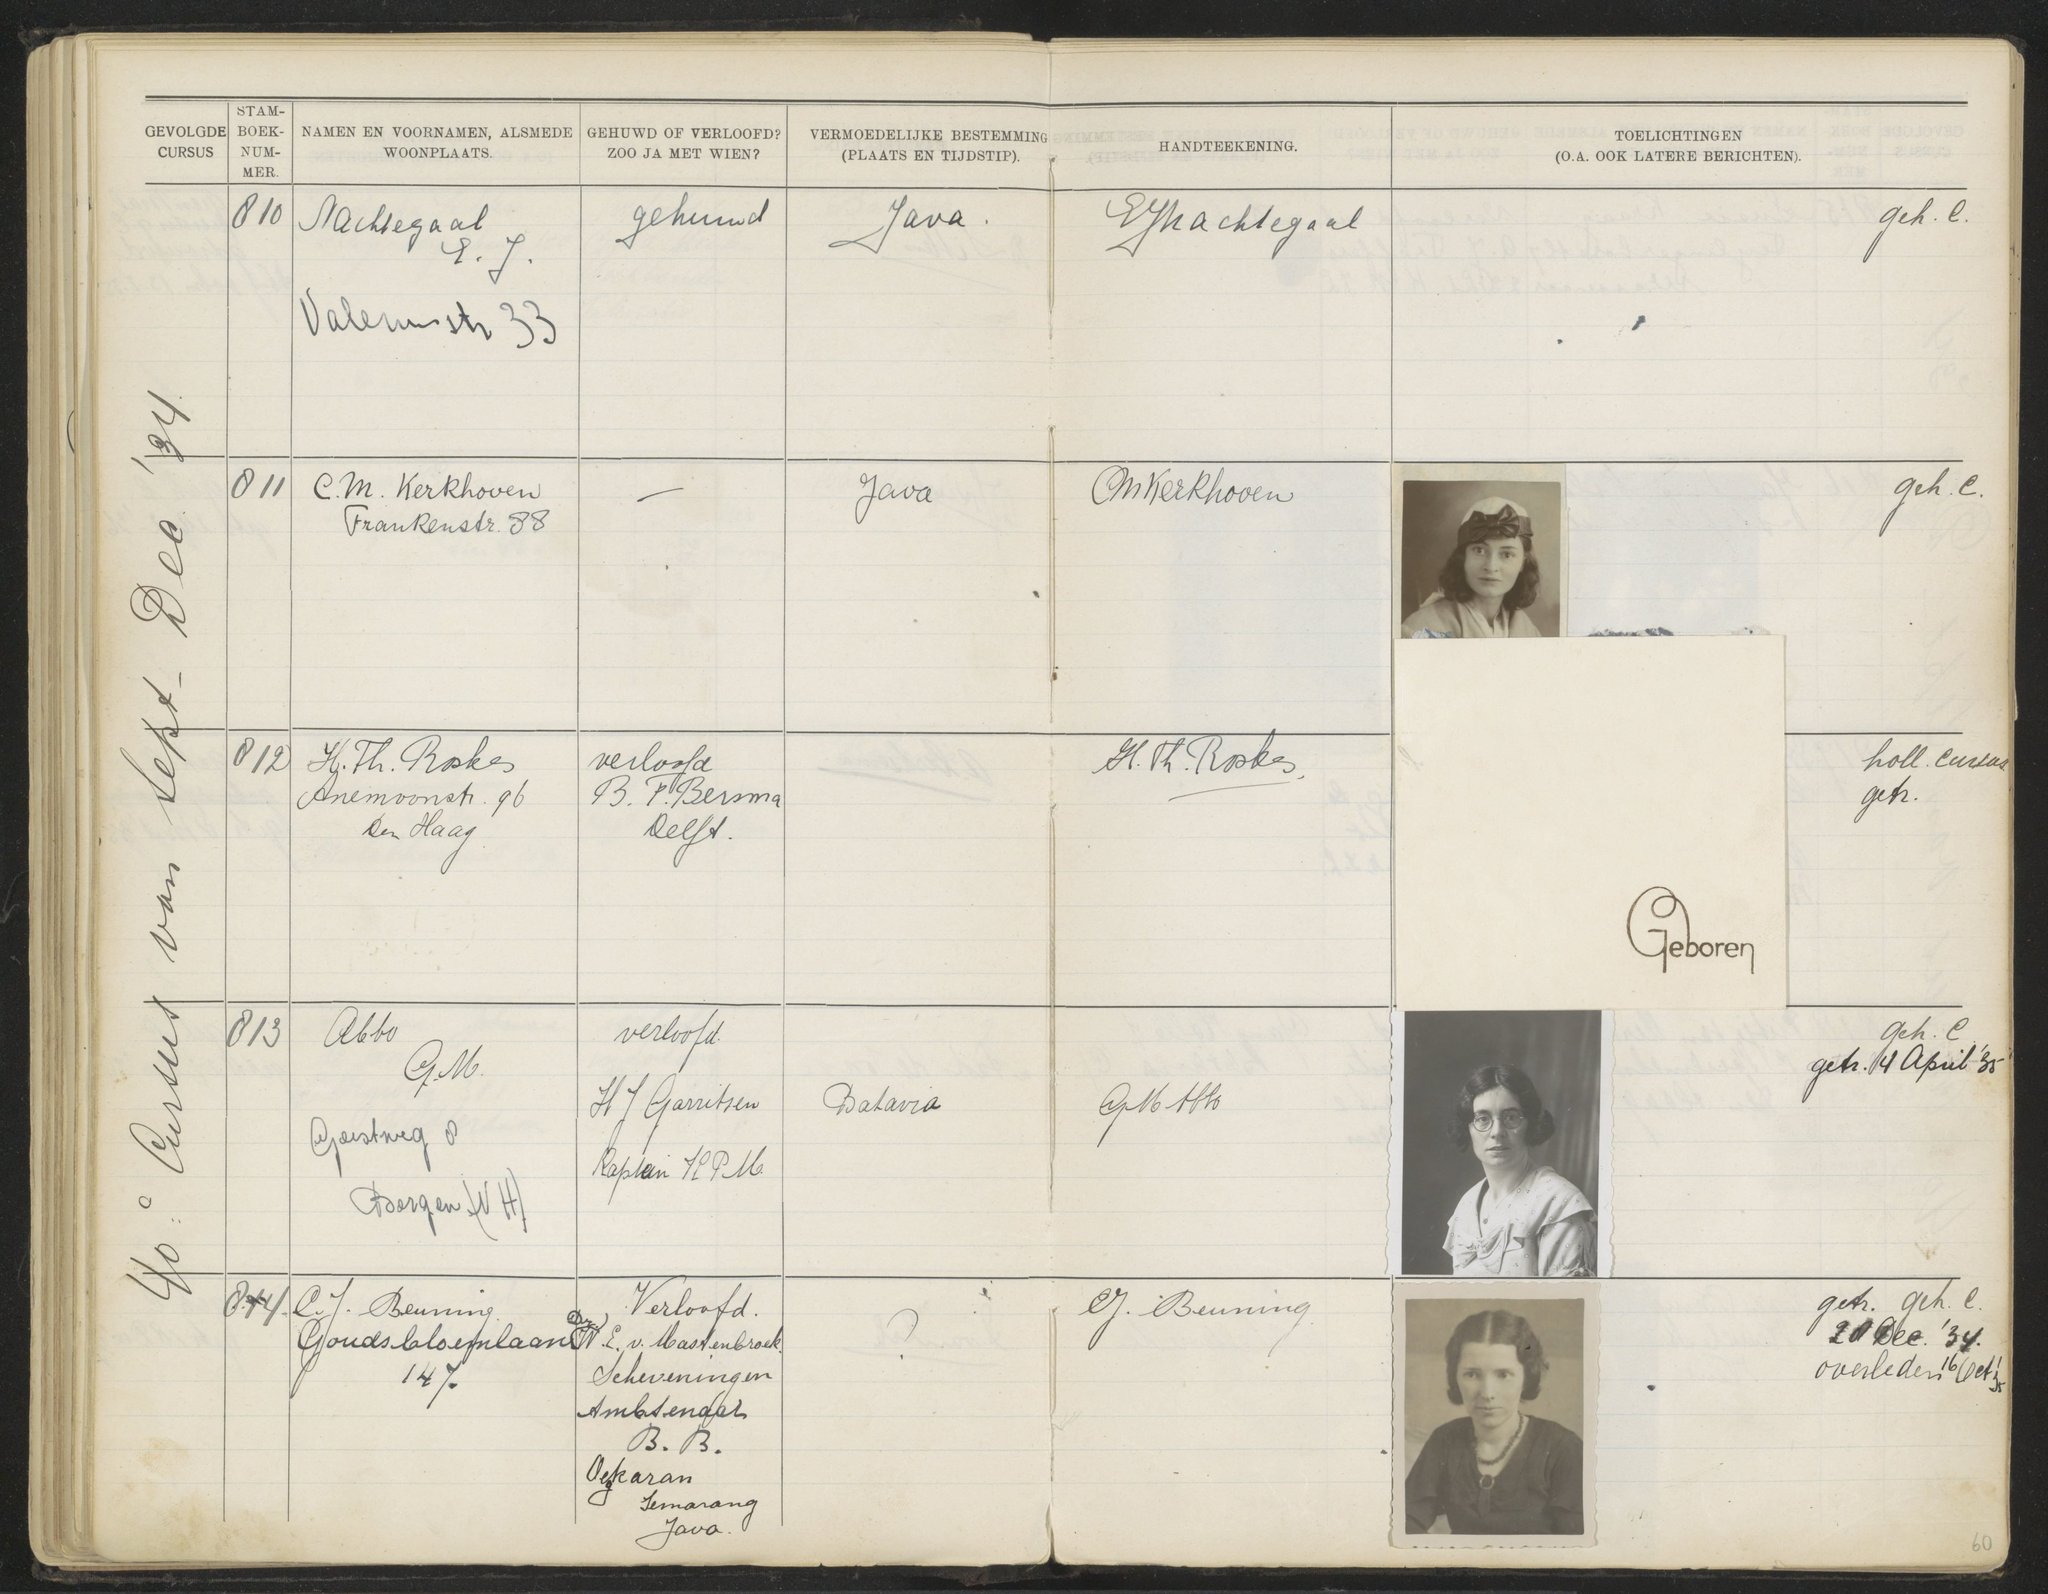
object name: photograph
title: Blad 60 uit Stamboek van de leerlingen der Koloniale School voor Meisjes en Vrouwen te 's-Gravenhage deel II (1930-1949)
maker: Anonymous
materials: paper, photographic support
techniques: photography, printing, writing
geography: the hague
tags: further education (+ pupil), further education, the hague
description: Twee pagina's met gegevens van de deelnemers aan de 40e driemaandelijkse cursus van september tot december 1934, stamboeknummers 810 tot en met 814. Onderdeel van Stamboek van de leerlingen der Koloniale School voor Meisjes en Vrouwen te 's-Gravenhage deel II (1930-1949).